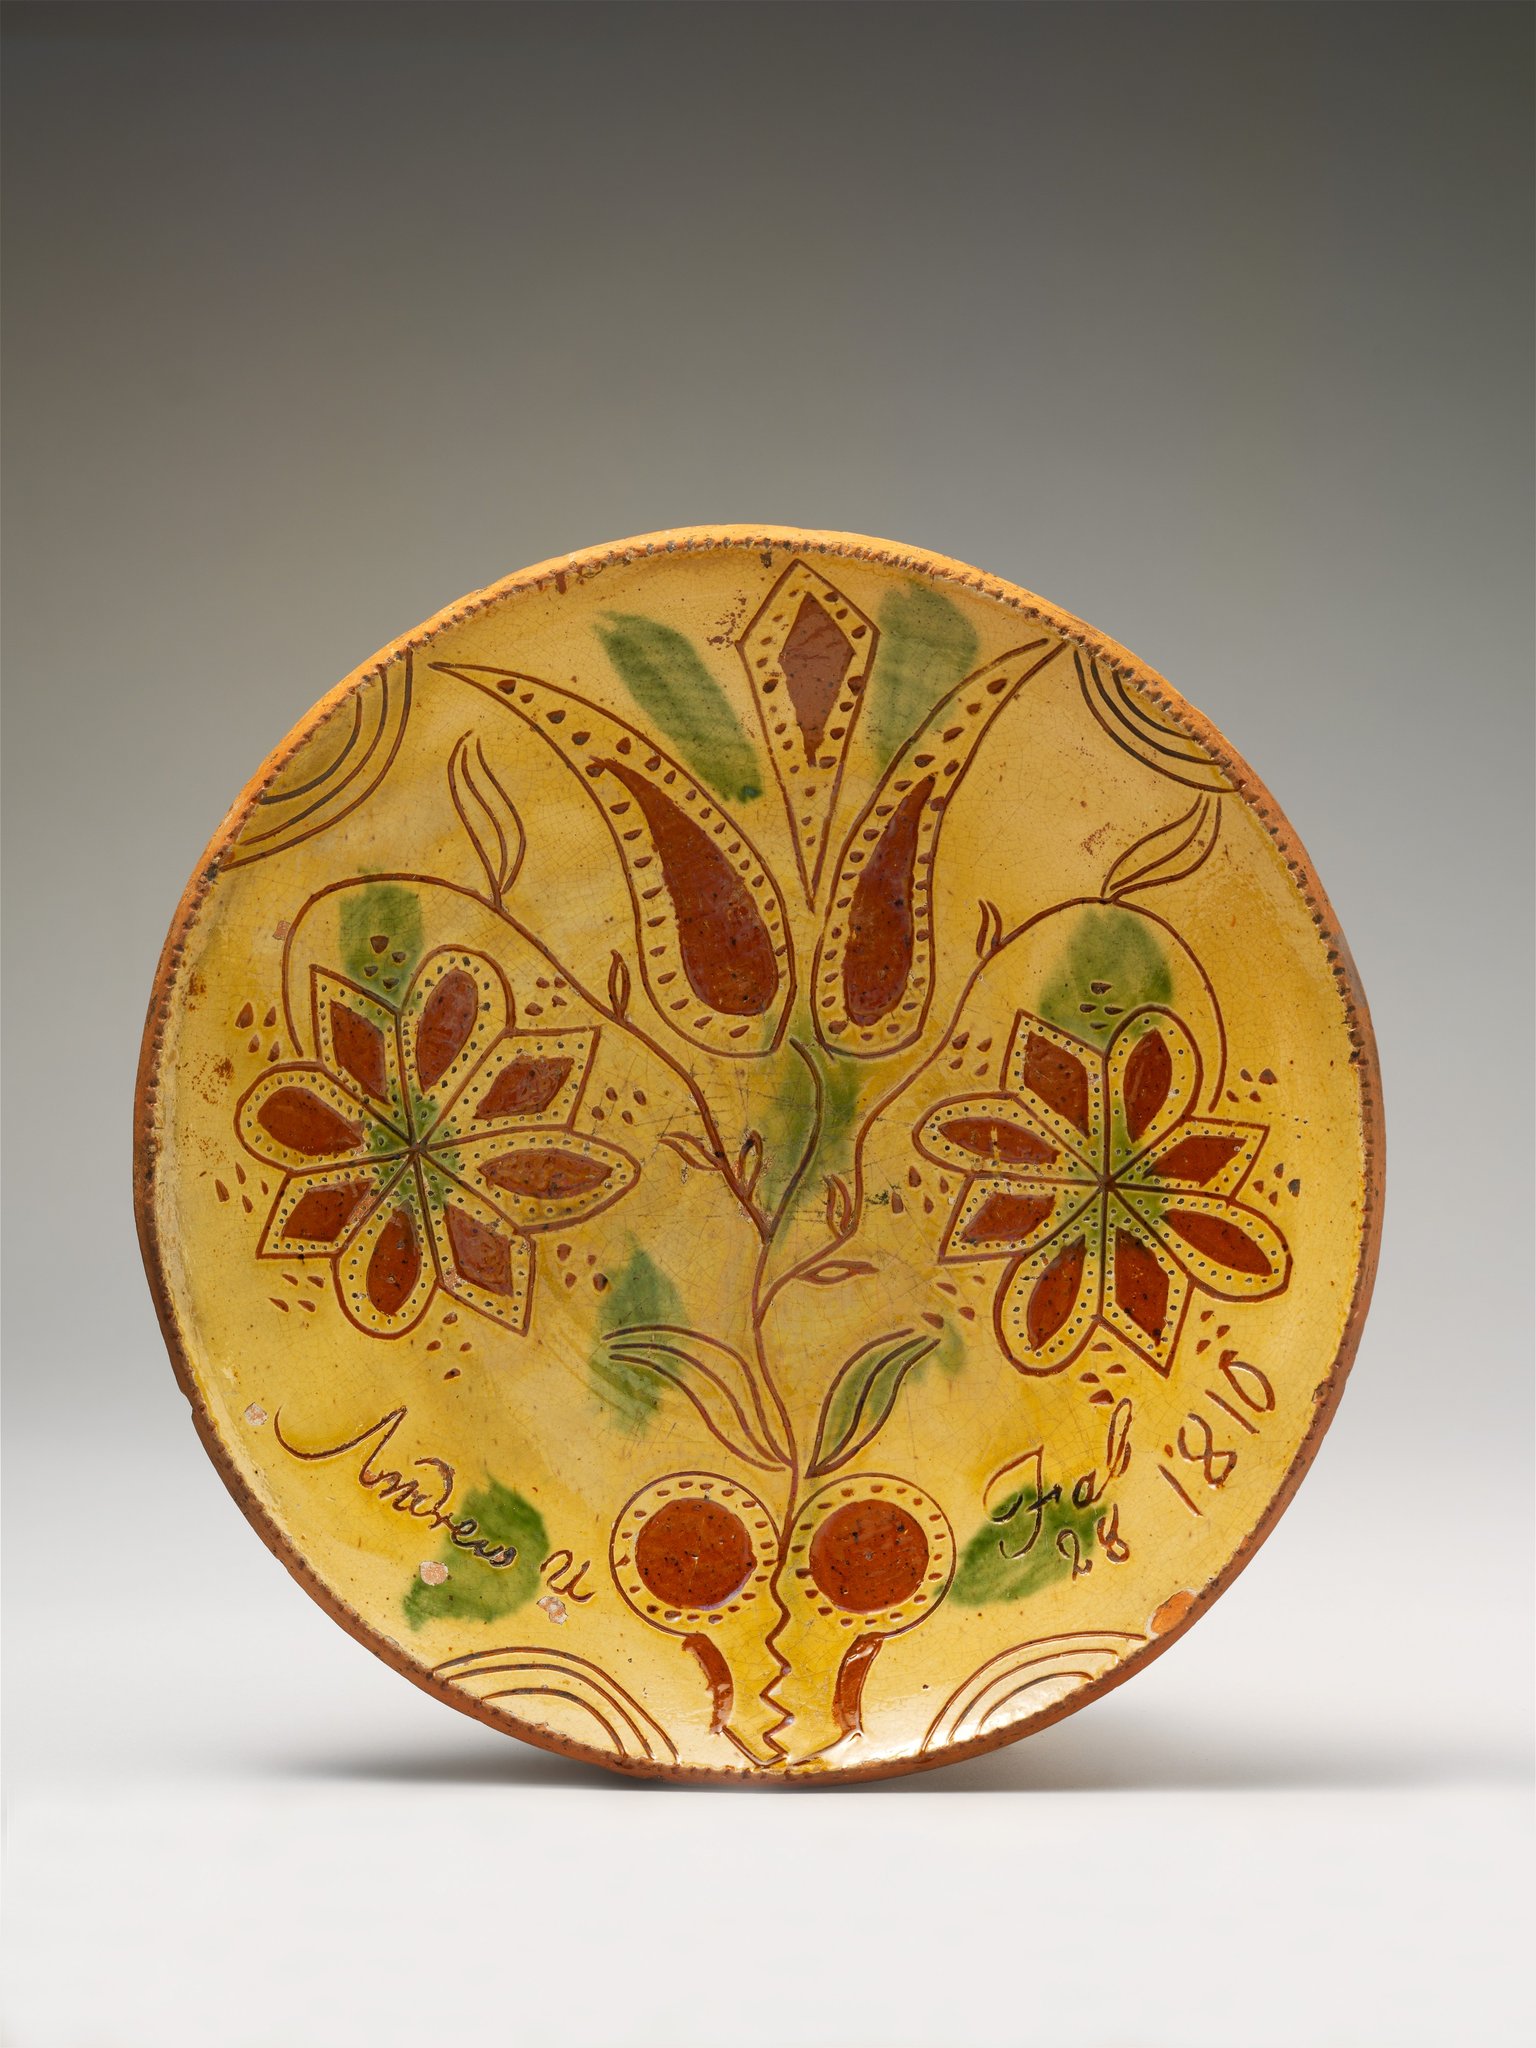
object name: plate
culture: american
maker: andrew uhler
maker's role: maker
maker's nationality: american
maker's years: 1798-1810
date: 1810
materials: earthenware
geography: united states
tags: flowers